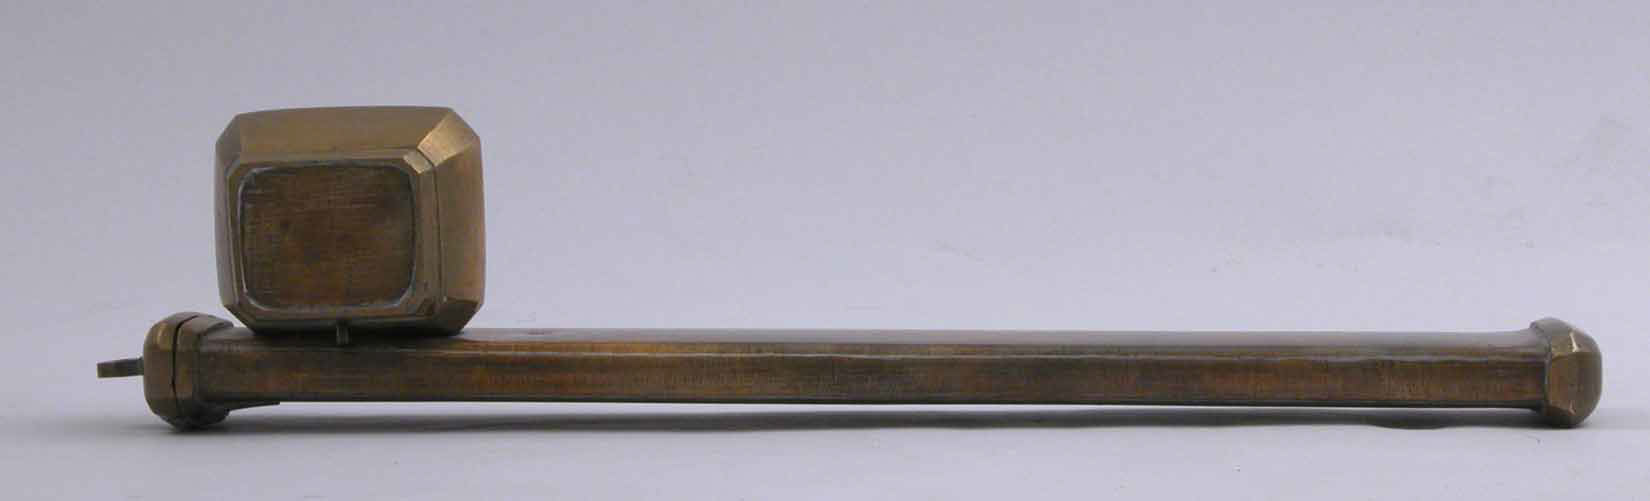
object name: pen case and inkwell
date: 1801-1900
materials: brass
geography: egypt or syria